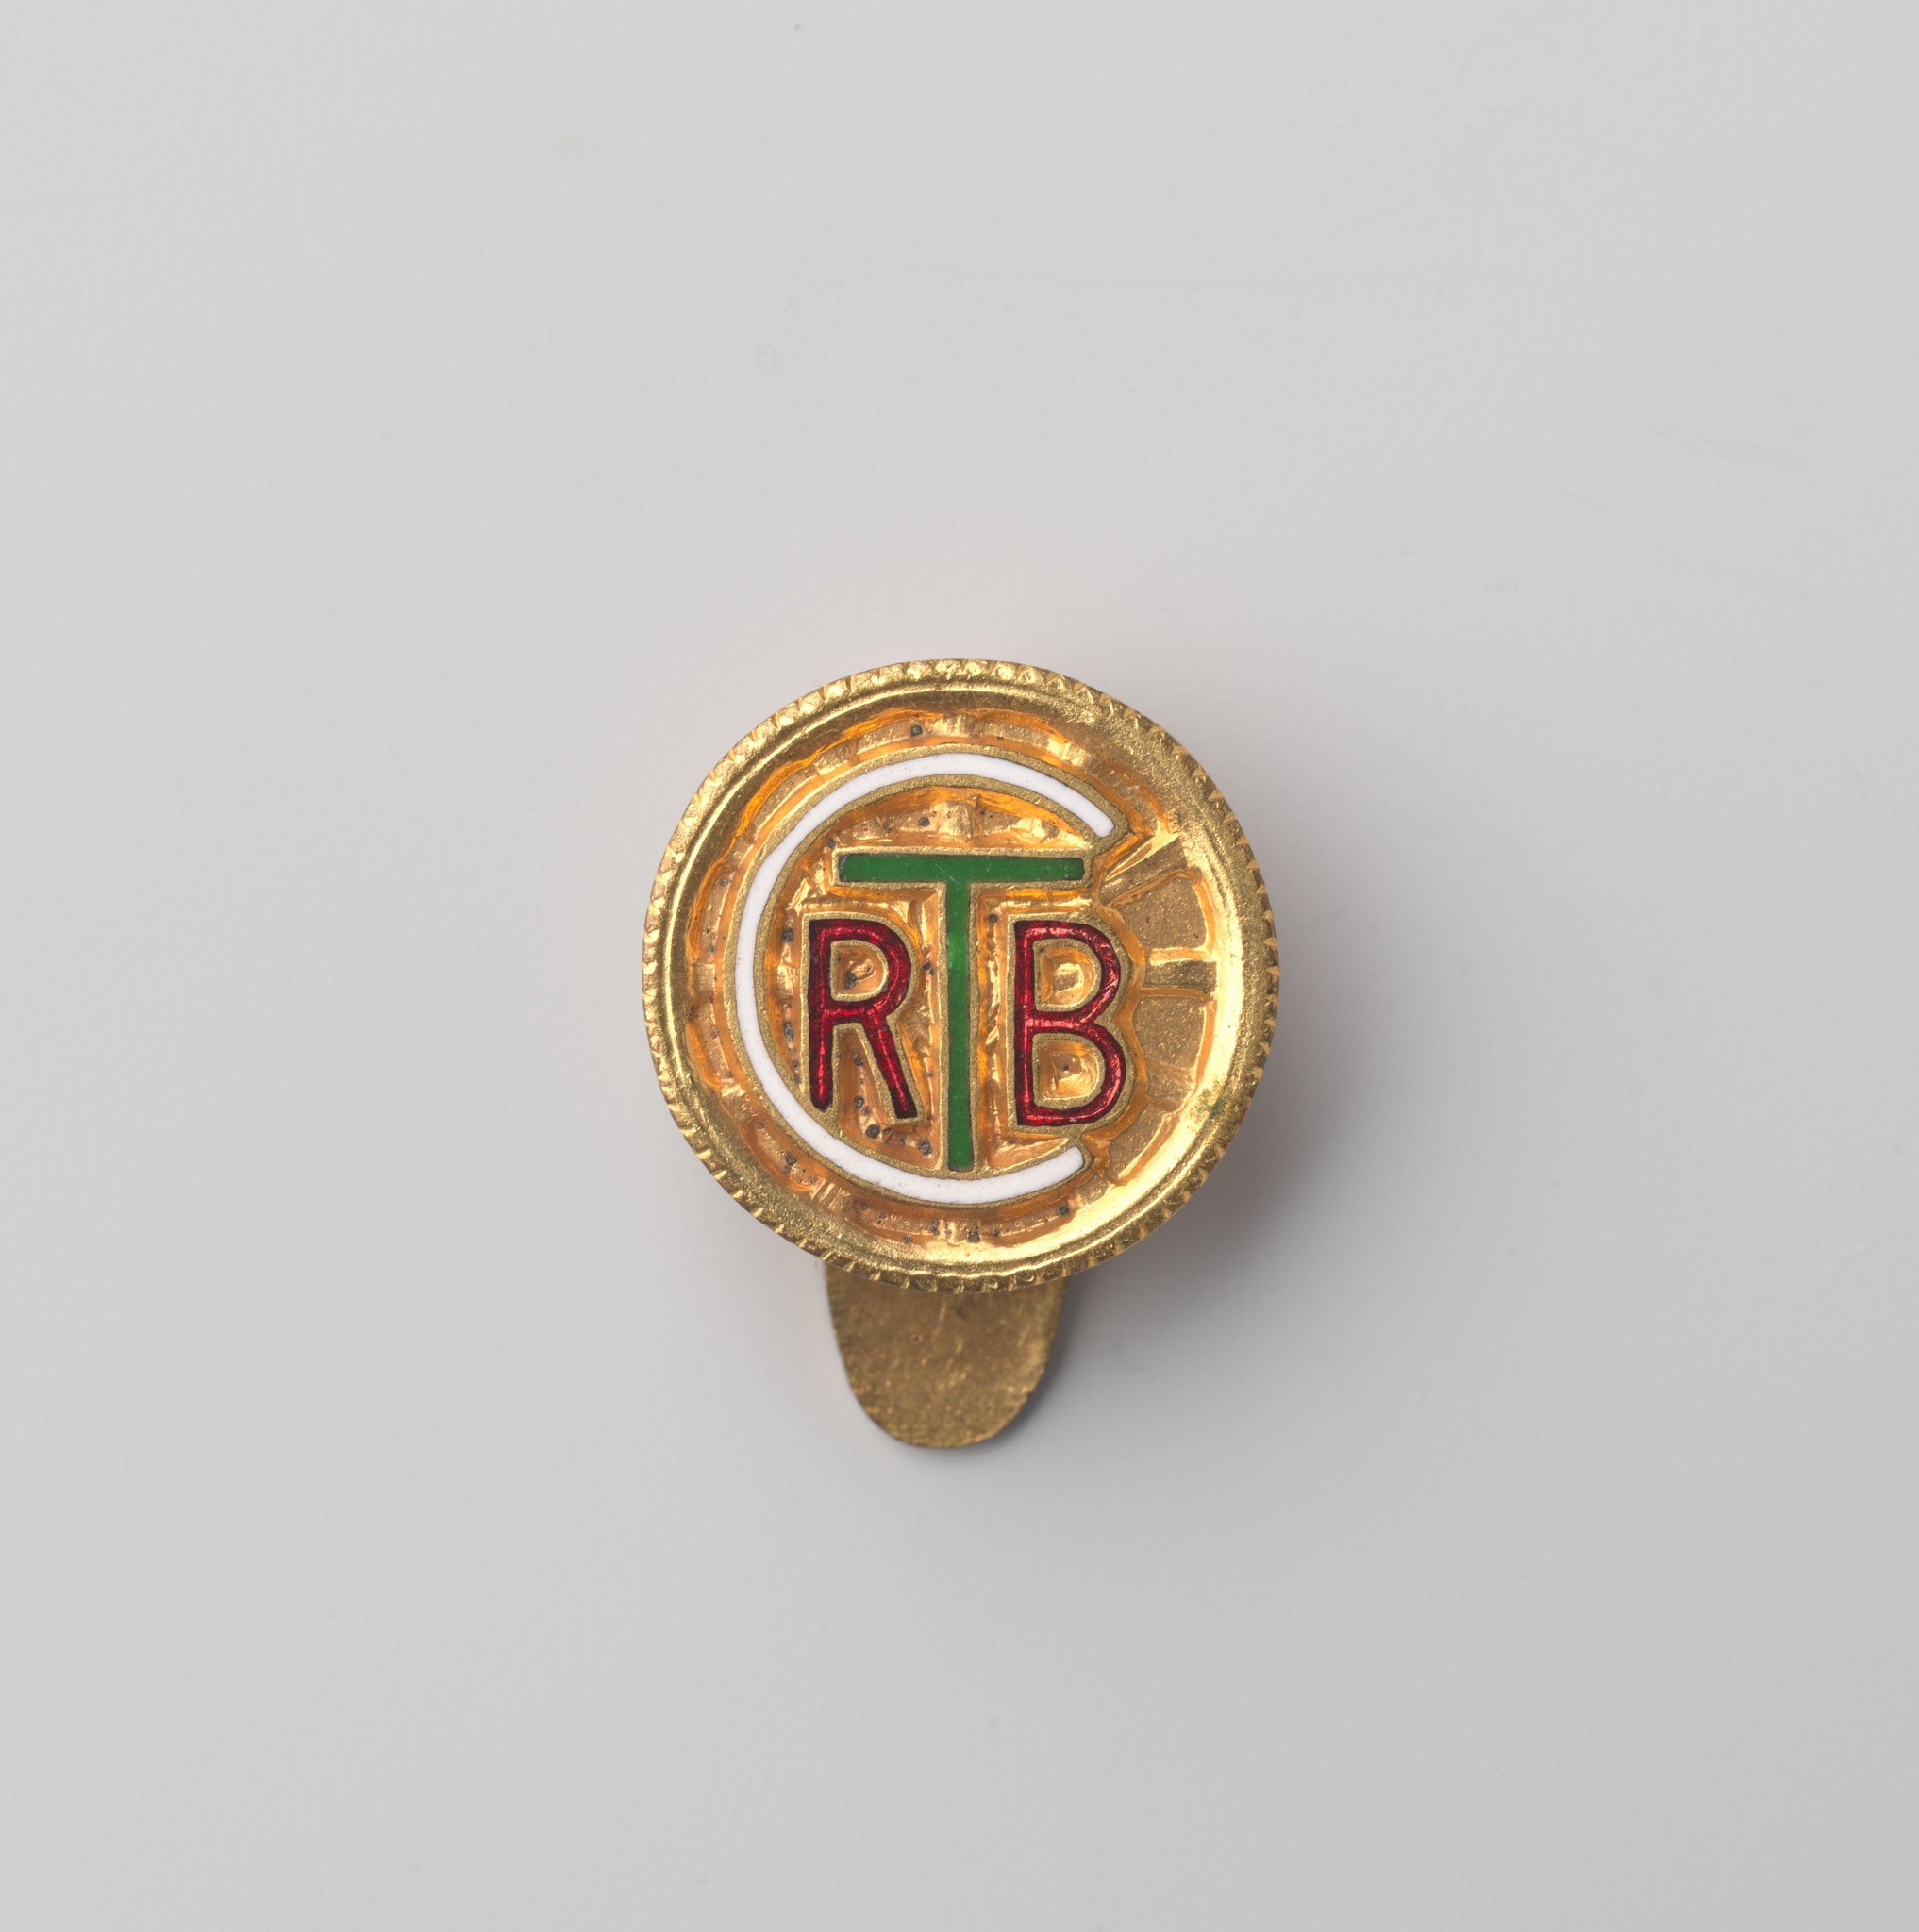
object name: cuff link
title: Manchetknoop met letters TCRB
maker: Anonymous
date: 1900-1925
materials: metal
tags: eugen wachenheimer, else wachenheimer-moos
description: Dit object is onderdeel van de nalatenschap van Isabel Elon-Wachenheimer (1928-2010). Tot haar overlijden behoorde het samen met de andere objecten uit de nalatenschap tot haar privédomein van Isabel Wachenheimer. In die particuliere context zijn deze objecten tezamen en individueel aandenkens - aan de jeugd, ouders en familie van Isabel Wachenheimer vóór en tijdens de Shoah en aan haar leven na de Tweede Wereldoorlog. Isabel Wachenheimer, die van juni 1943 tot mei 1945 gevangen zat in Kamp Westerbork, Theresienstadt, Auschwitz, Lenzing a/d Oberdonau (een buitenkamp van Mauthausen), overleefde de Shoah. Haar ouders – Eugène Wachenheimer en Else Wachenheimer-Moos - werden op 14 oktober 1944 in Auschwitz-Birkenau vermoord.